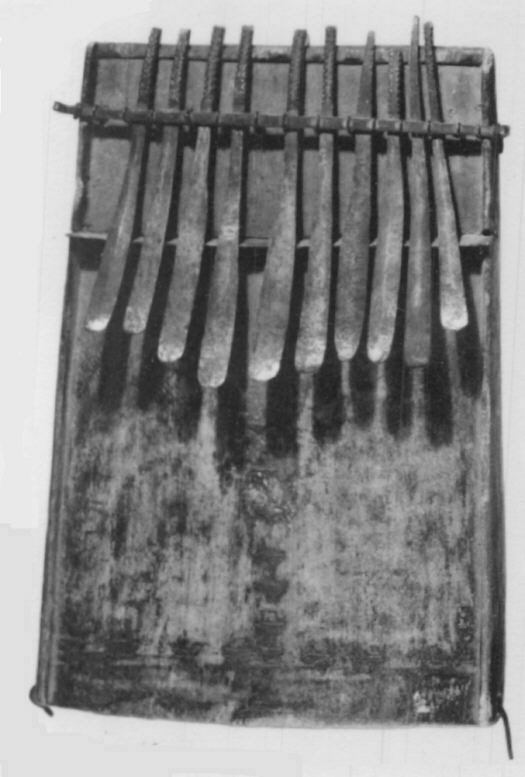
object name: zanze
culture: angolan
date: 1867-1900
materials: metal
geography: angola